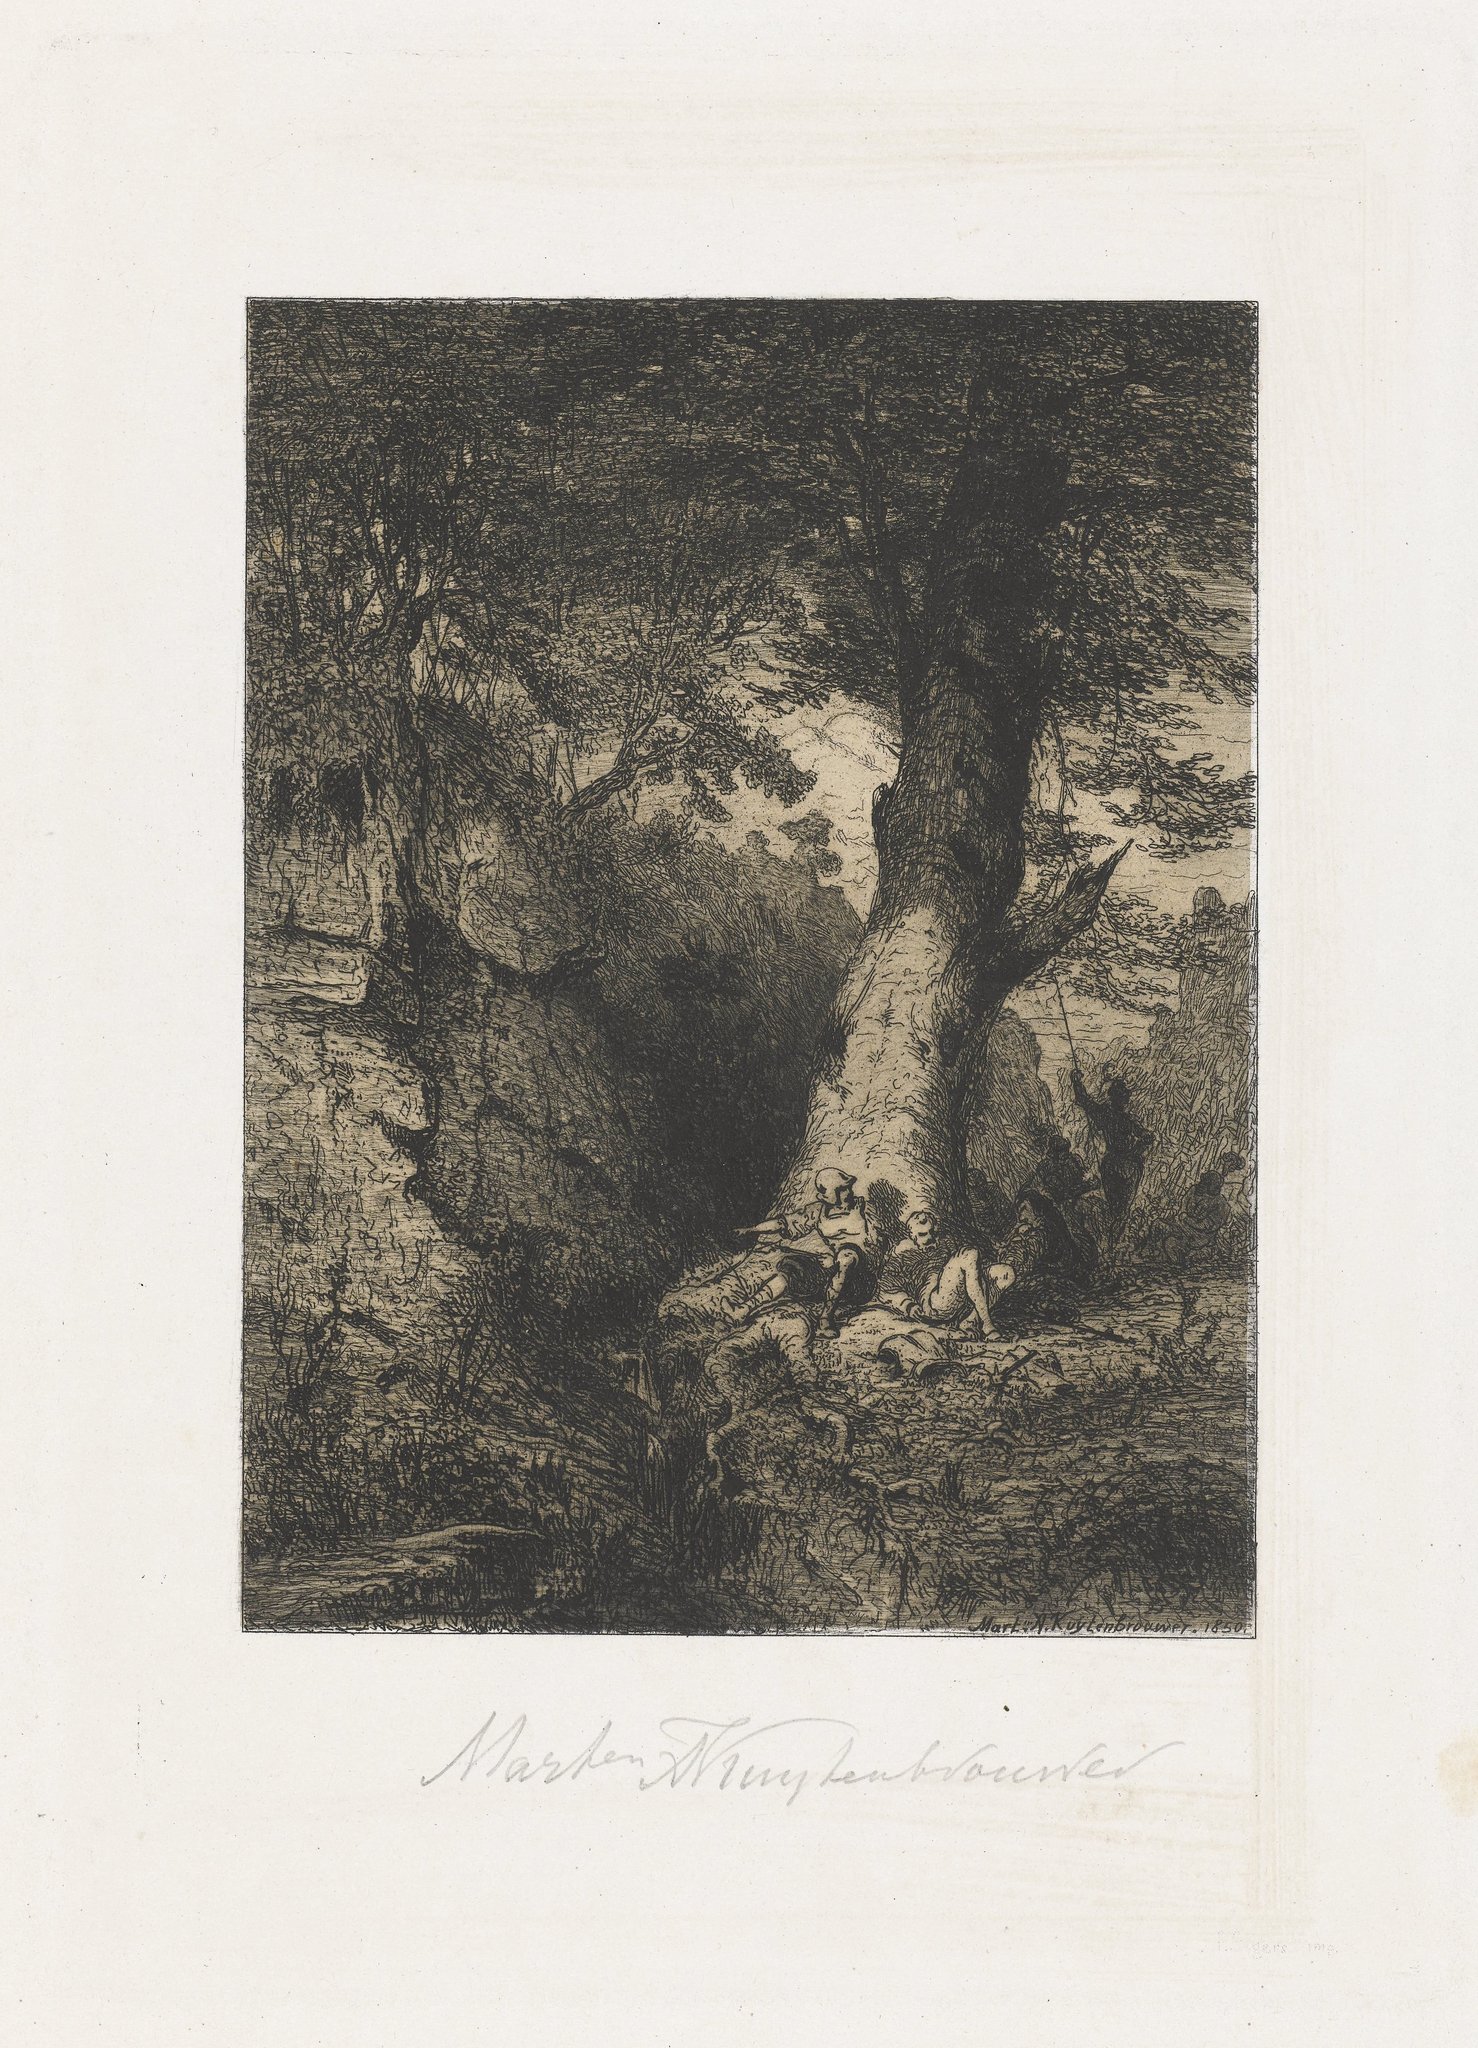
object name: print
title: Rustende krijgsmannen onder een boom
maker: martinus antonius kuytenbrouwer jr.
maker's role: draughtsman, painter, print maker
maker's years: 1821-1897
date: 1850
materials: paper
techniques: drypoint, etching, intaglio, roulette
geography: brussels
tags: low hill country, (high) hill, recreation ~ the soldier off duty, (military) uniforms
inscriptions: collector's mark: Lugt 2228, inscription: ‘Marten Kuytenbrouwer’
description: In een bergachtig landschap bevinden zich een aantal soldaten onder een boom.